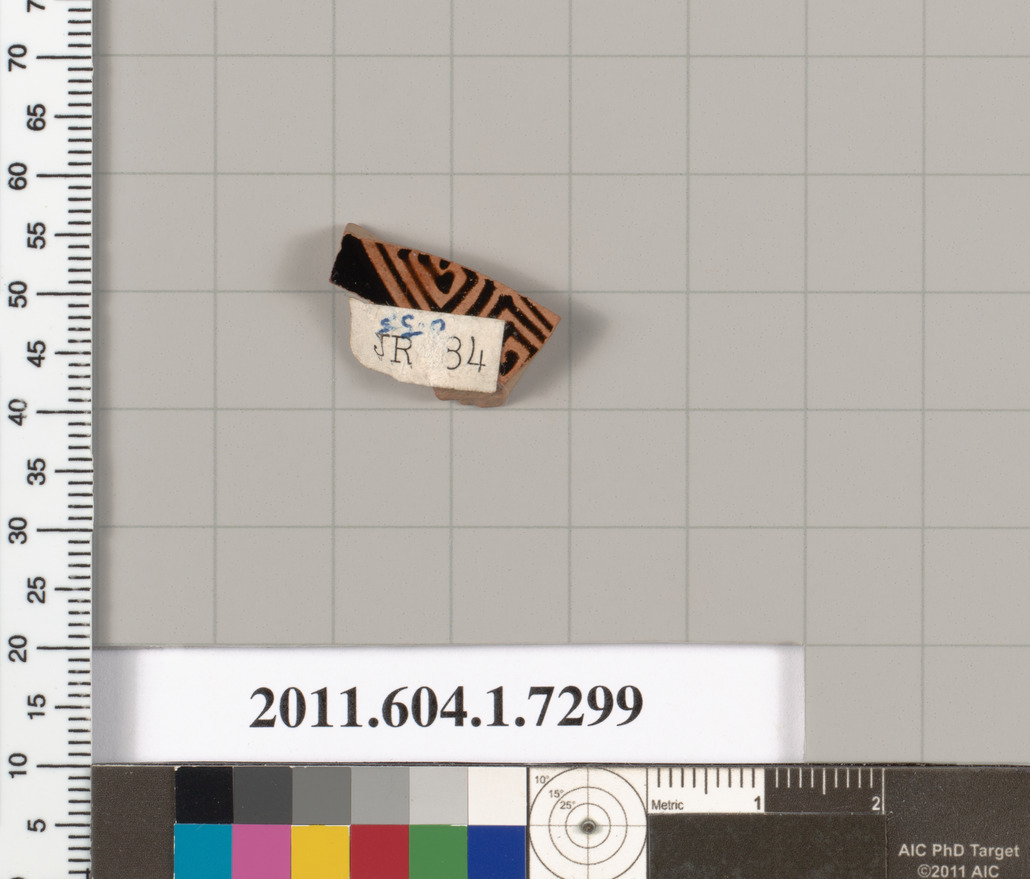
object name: kylix fragment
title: Terracotta fragment of a kylix (drinking cup)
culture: greek, attic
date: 500-480 BCE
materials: terracotta